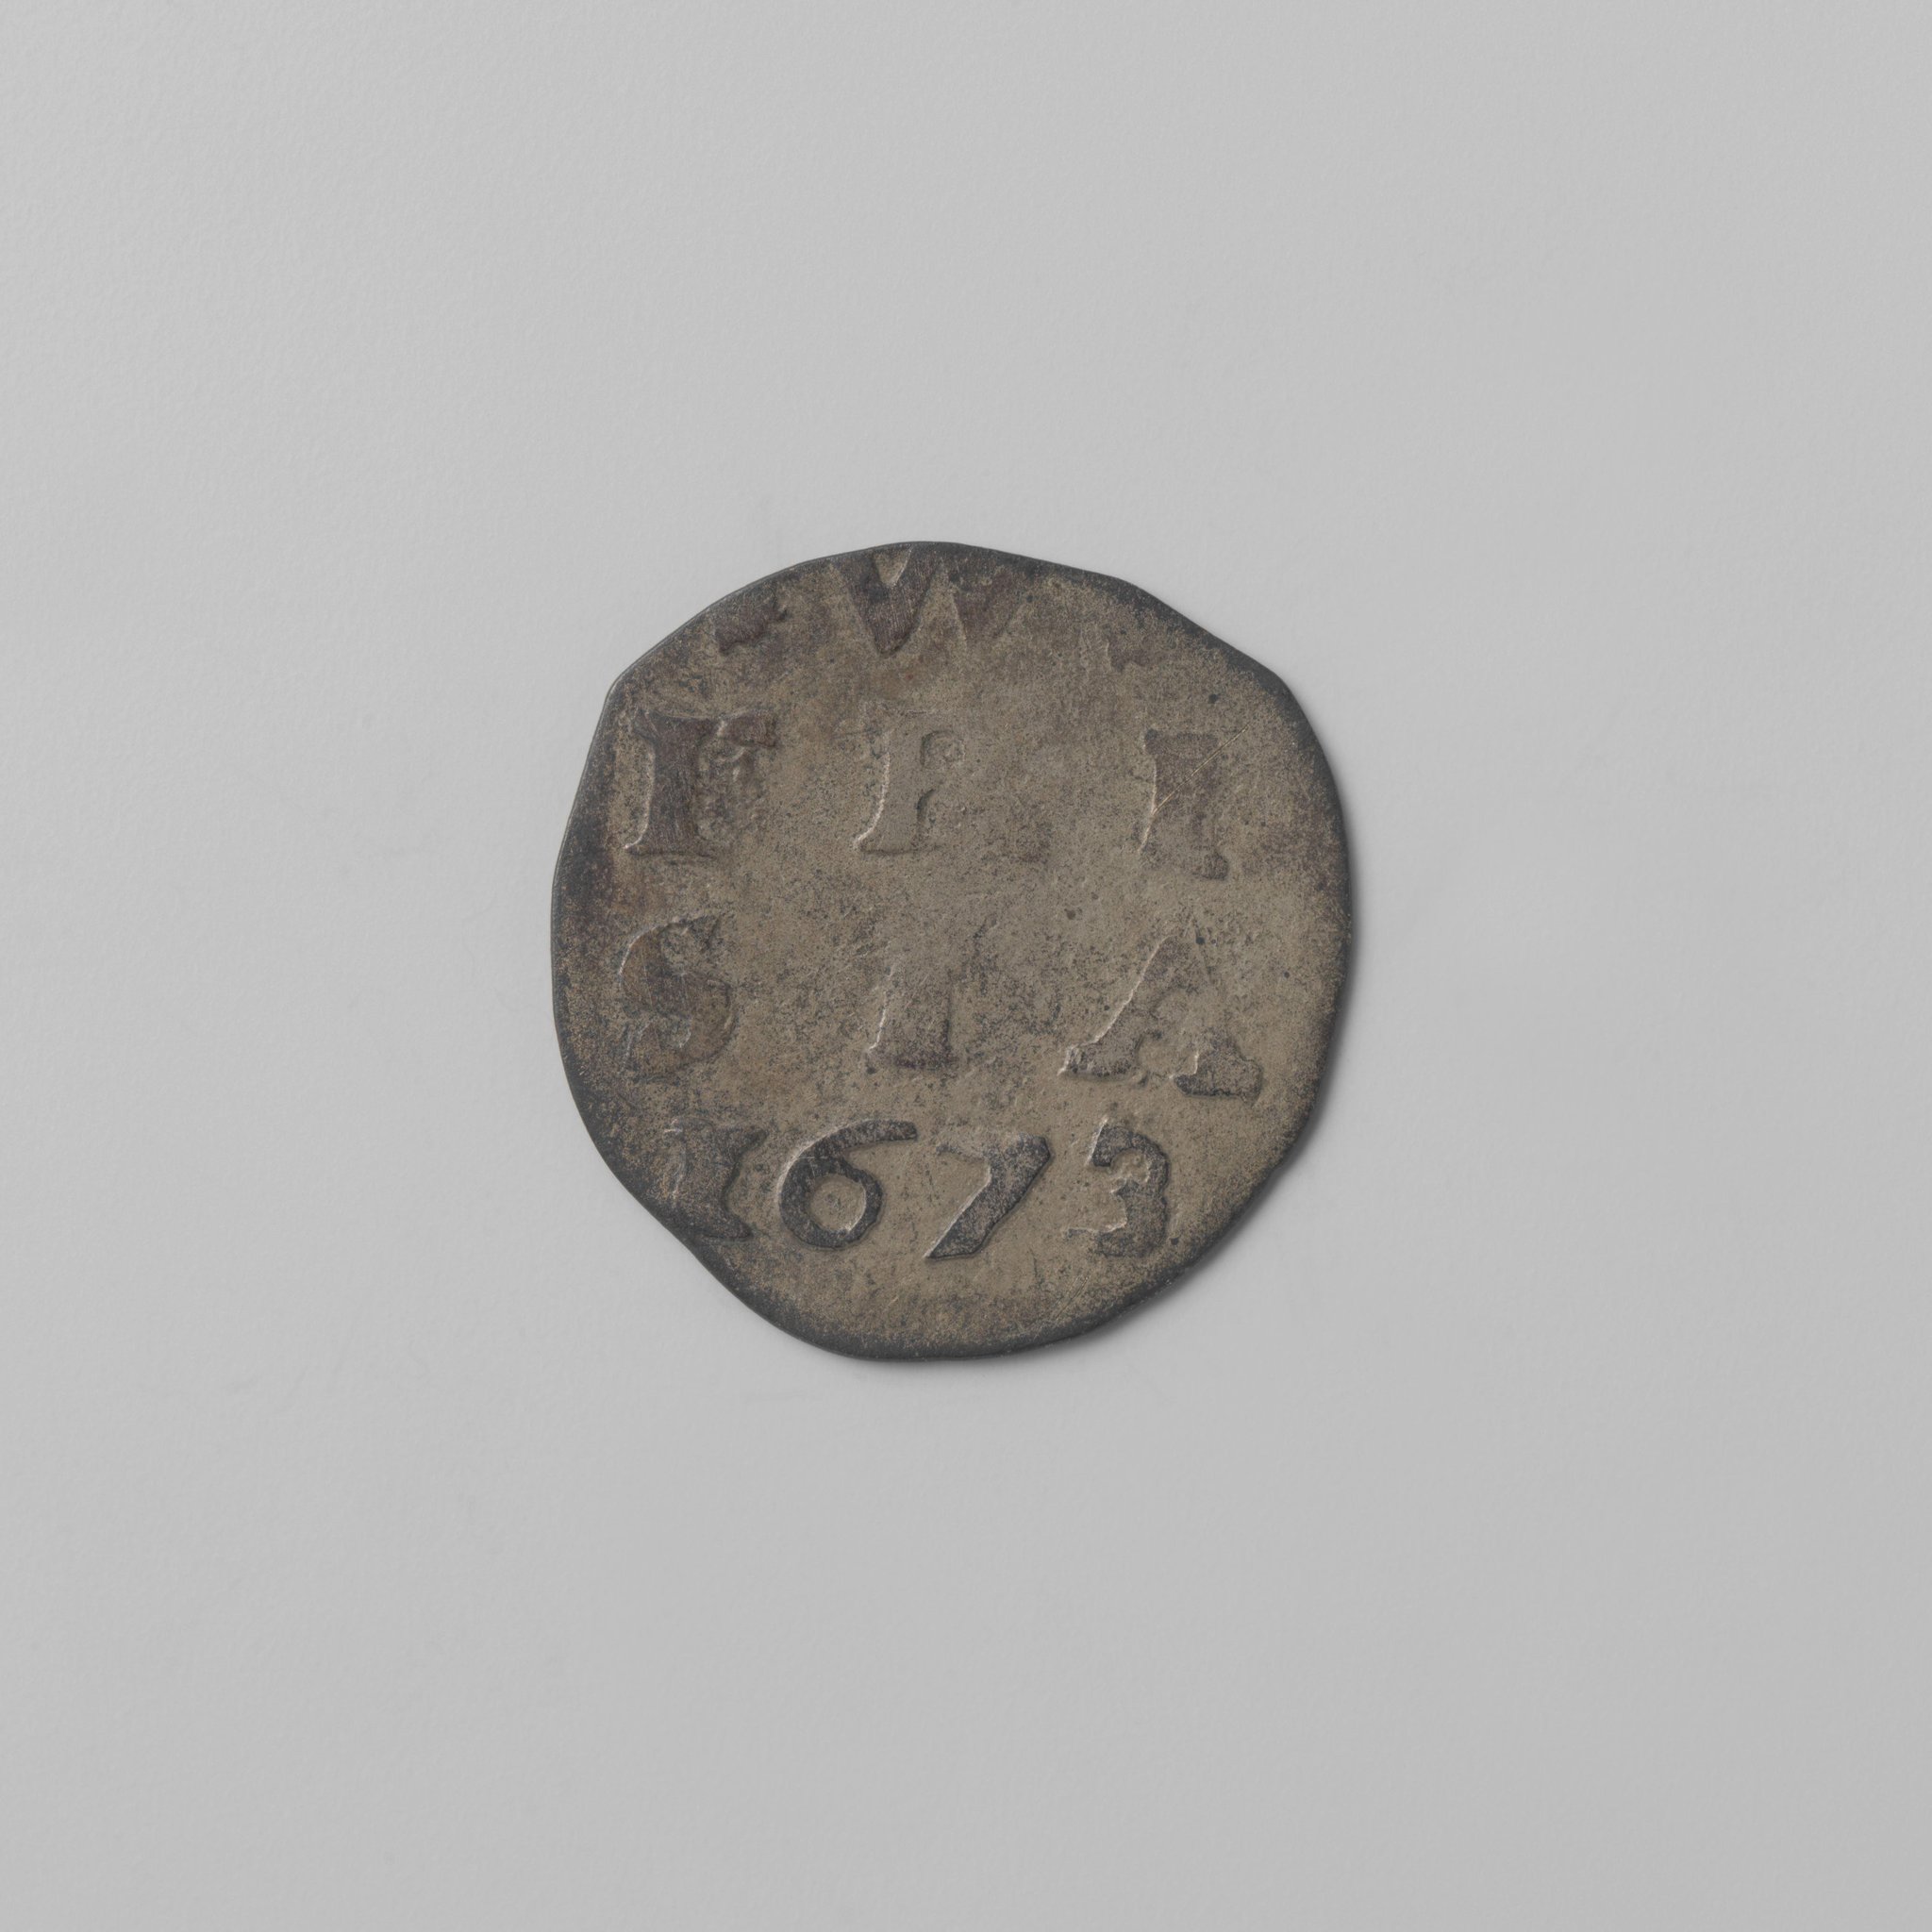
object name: coin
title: Westfriese dubbele stuiver, 1673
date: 1673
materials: silver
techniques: striking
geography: west frisia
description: Zilveren munt. Voorzijde: tussen waarde-aanduiding 2 S klimmende leeuw naar links, in linkerklauw pijlenbundel , in rechterklauw zwaard. Keerzijde: opschrift in drie regels. Daaronder jaartal.